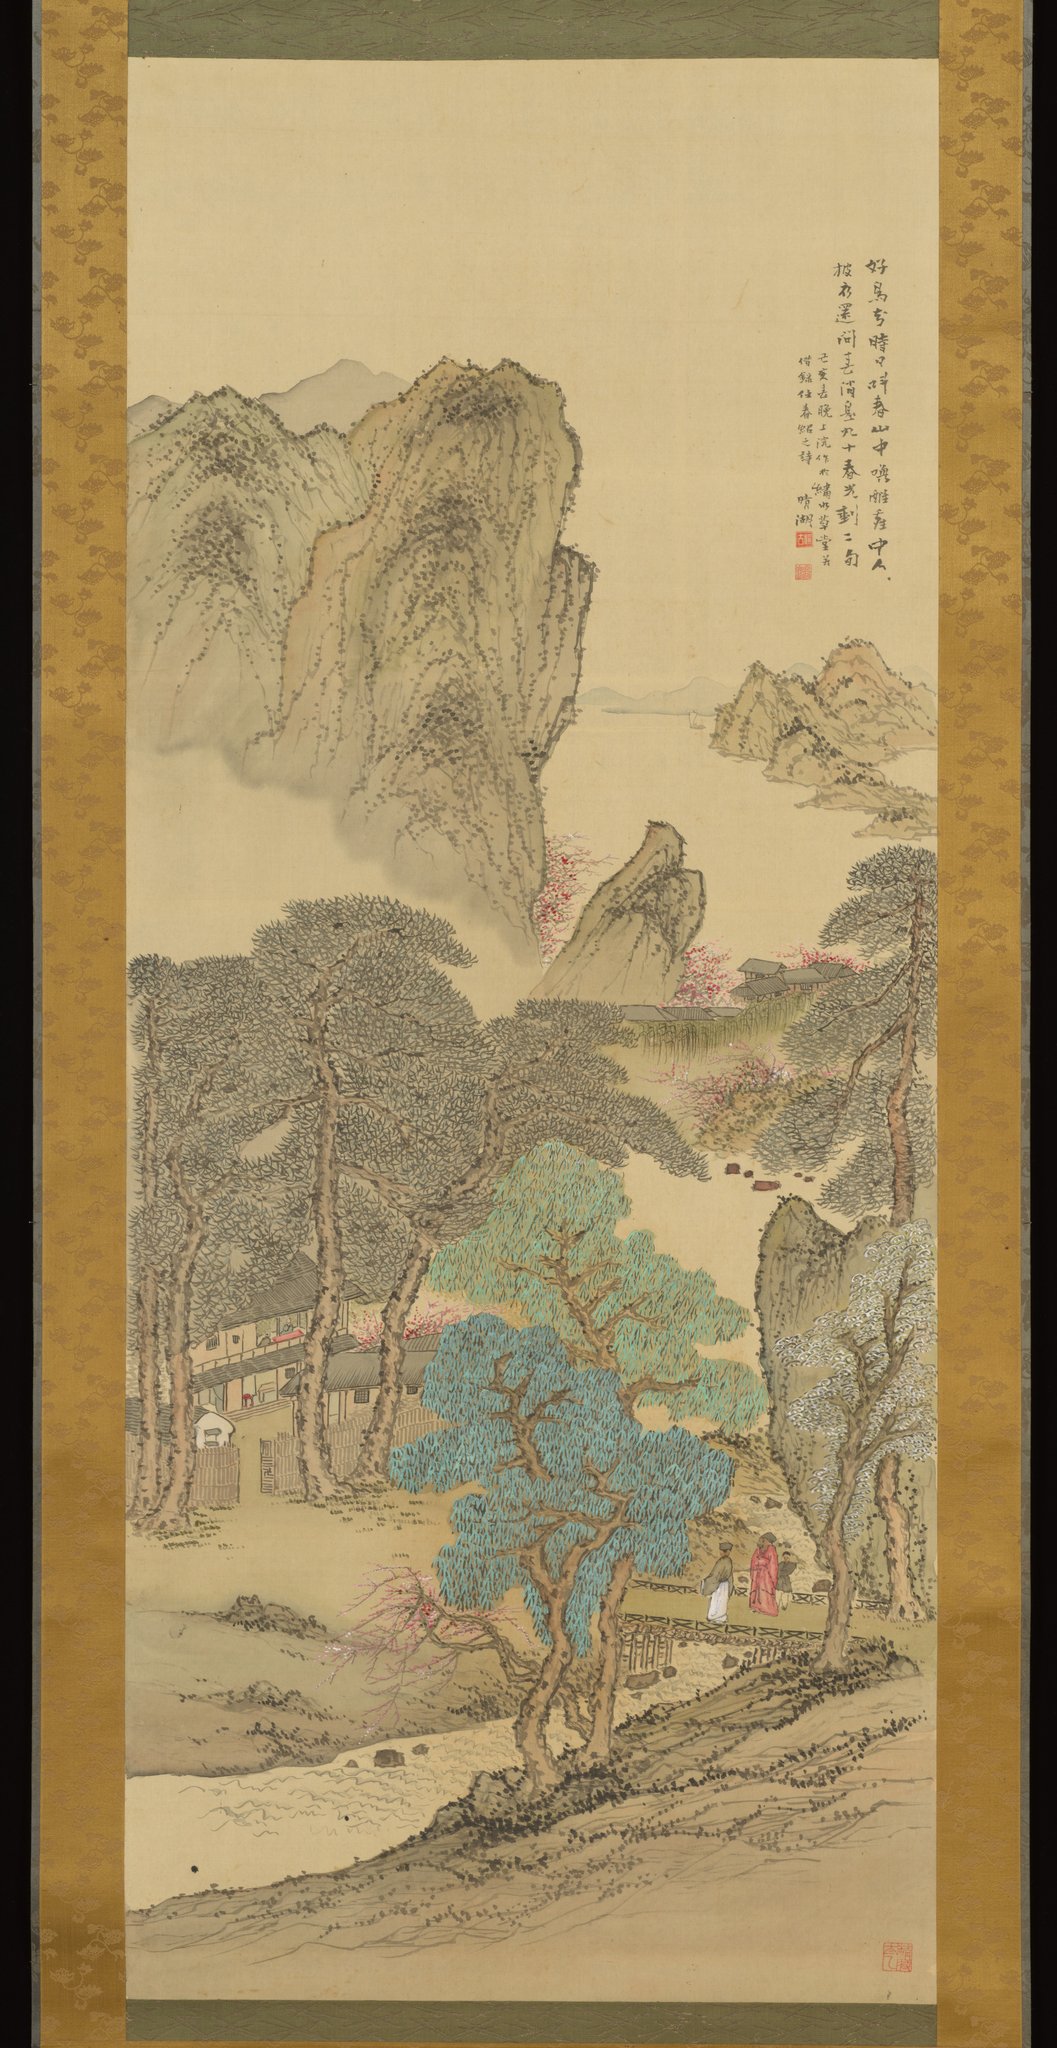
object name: hanging scroll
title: Landscape in Blue and Green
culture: japanese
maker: okuhara seiko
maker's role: artist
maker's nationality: japanese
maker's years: 1837-1913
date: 1899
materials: ink, silk